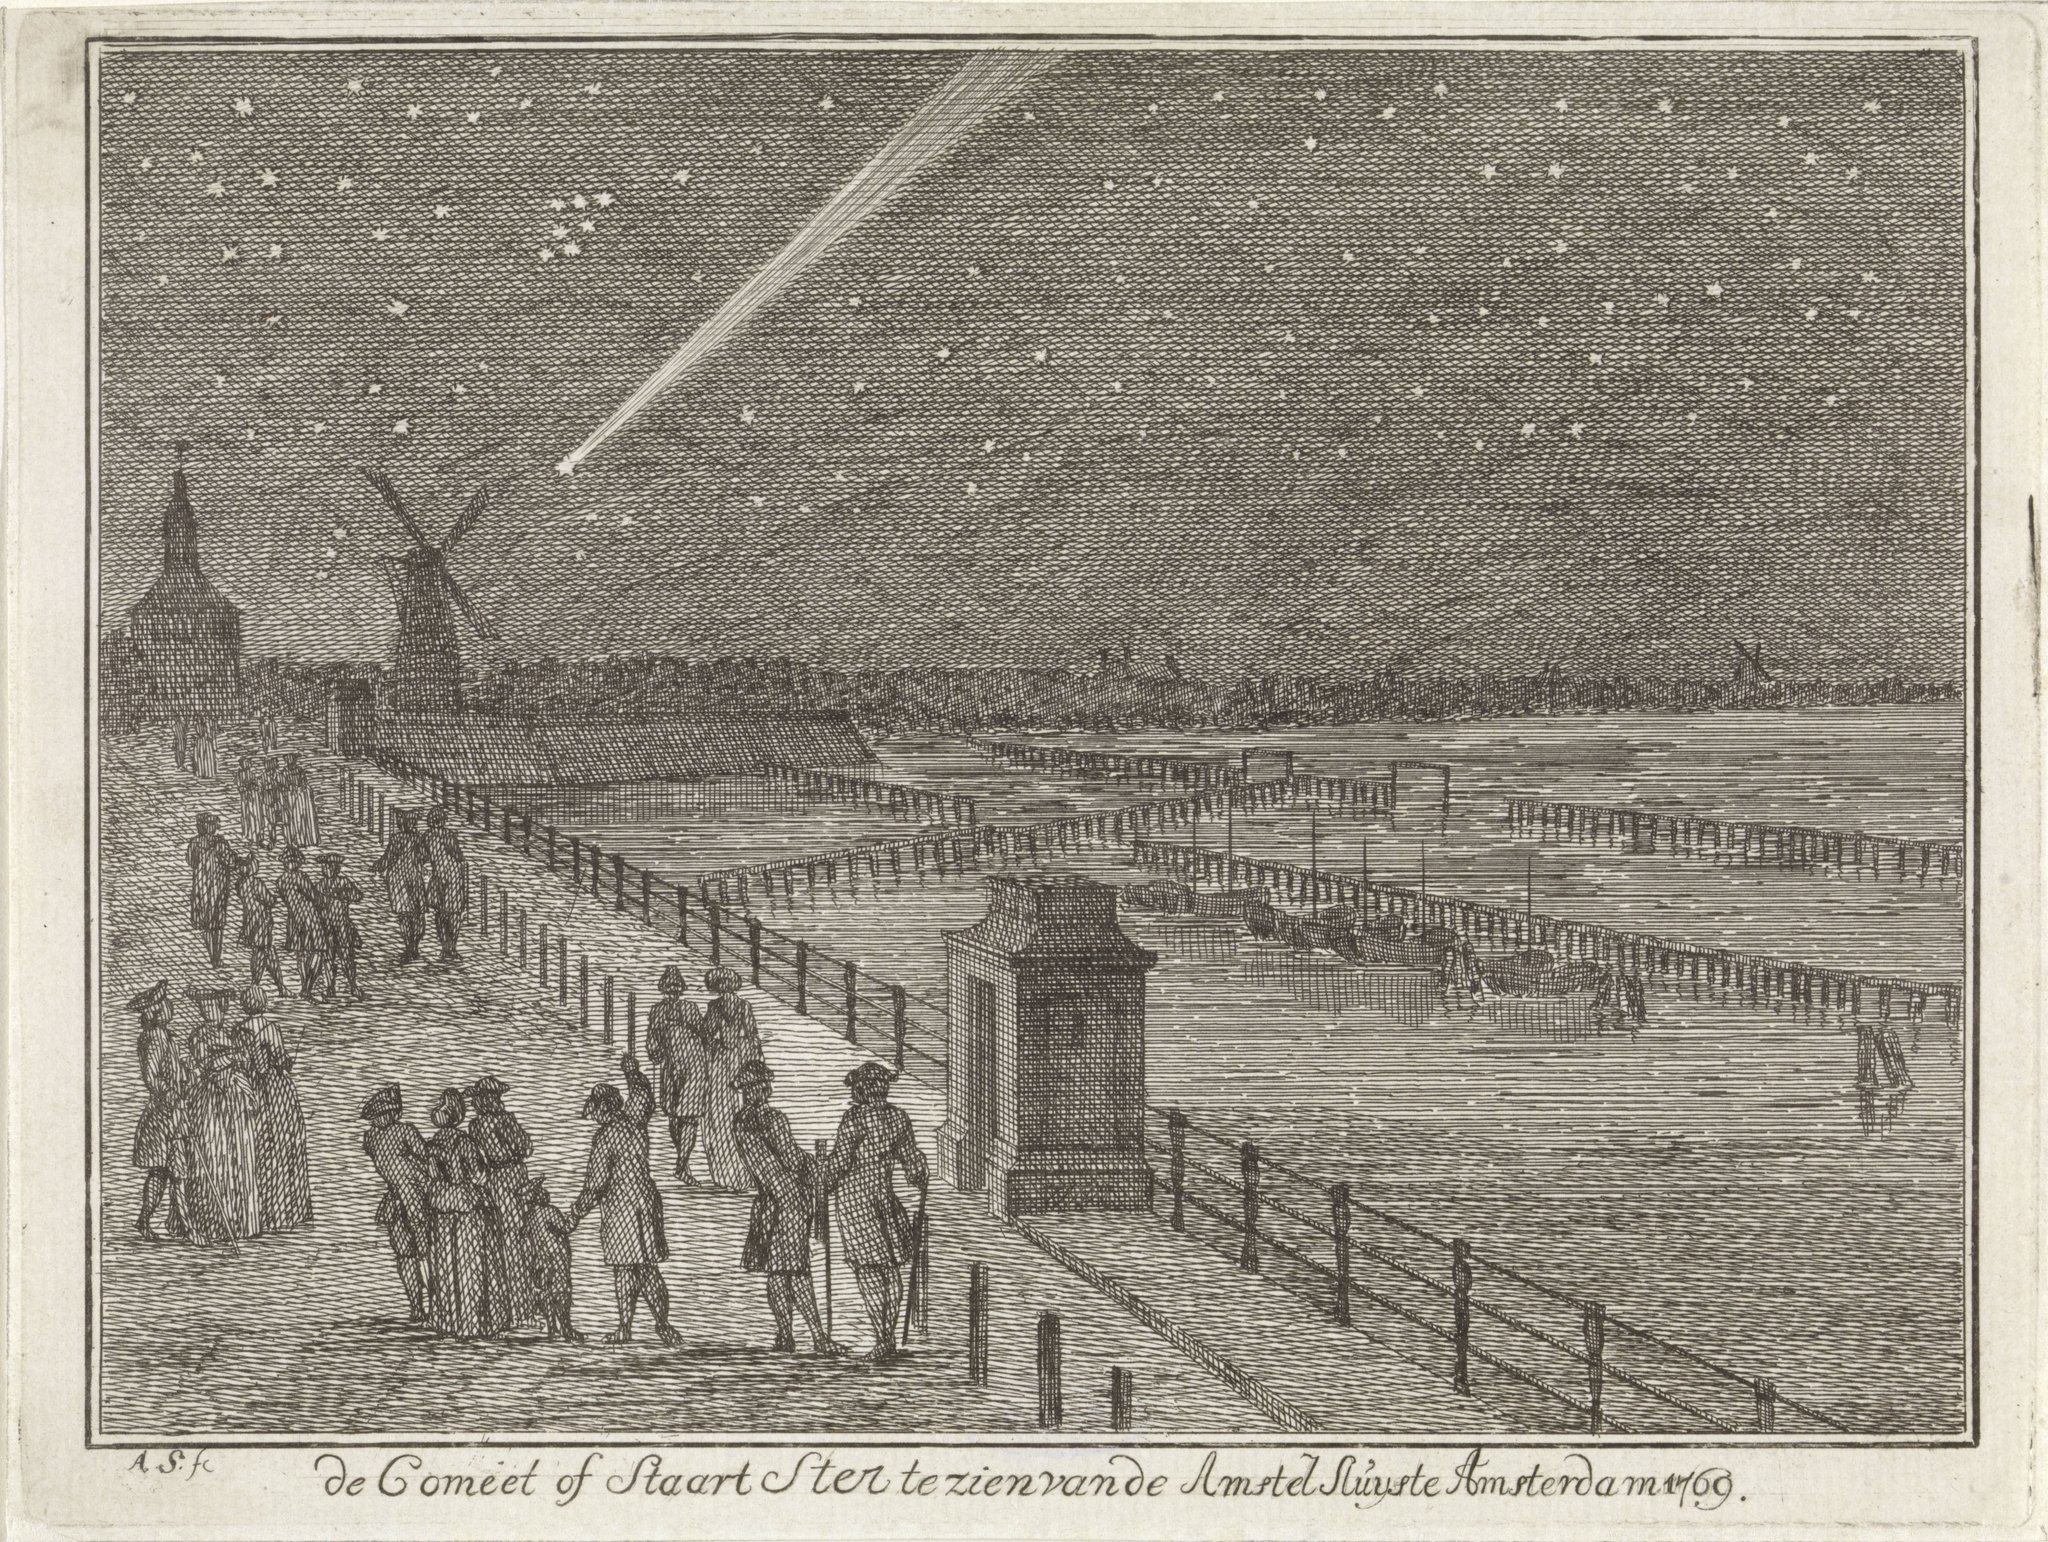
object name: print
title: Komeet boven Amsterdam, 1769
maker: aert schouman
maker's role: draughtsman, painter, print maker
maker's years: 1710-1792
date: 1769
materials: paper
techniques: etching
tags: comet, amsterdam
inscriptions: collector's mark: Lugt 2228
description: Nachtvoorstelling met een komeet aan de hemel boven de Amstelsuis te Amsterdam, augustus-september 1769.